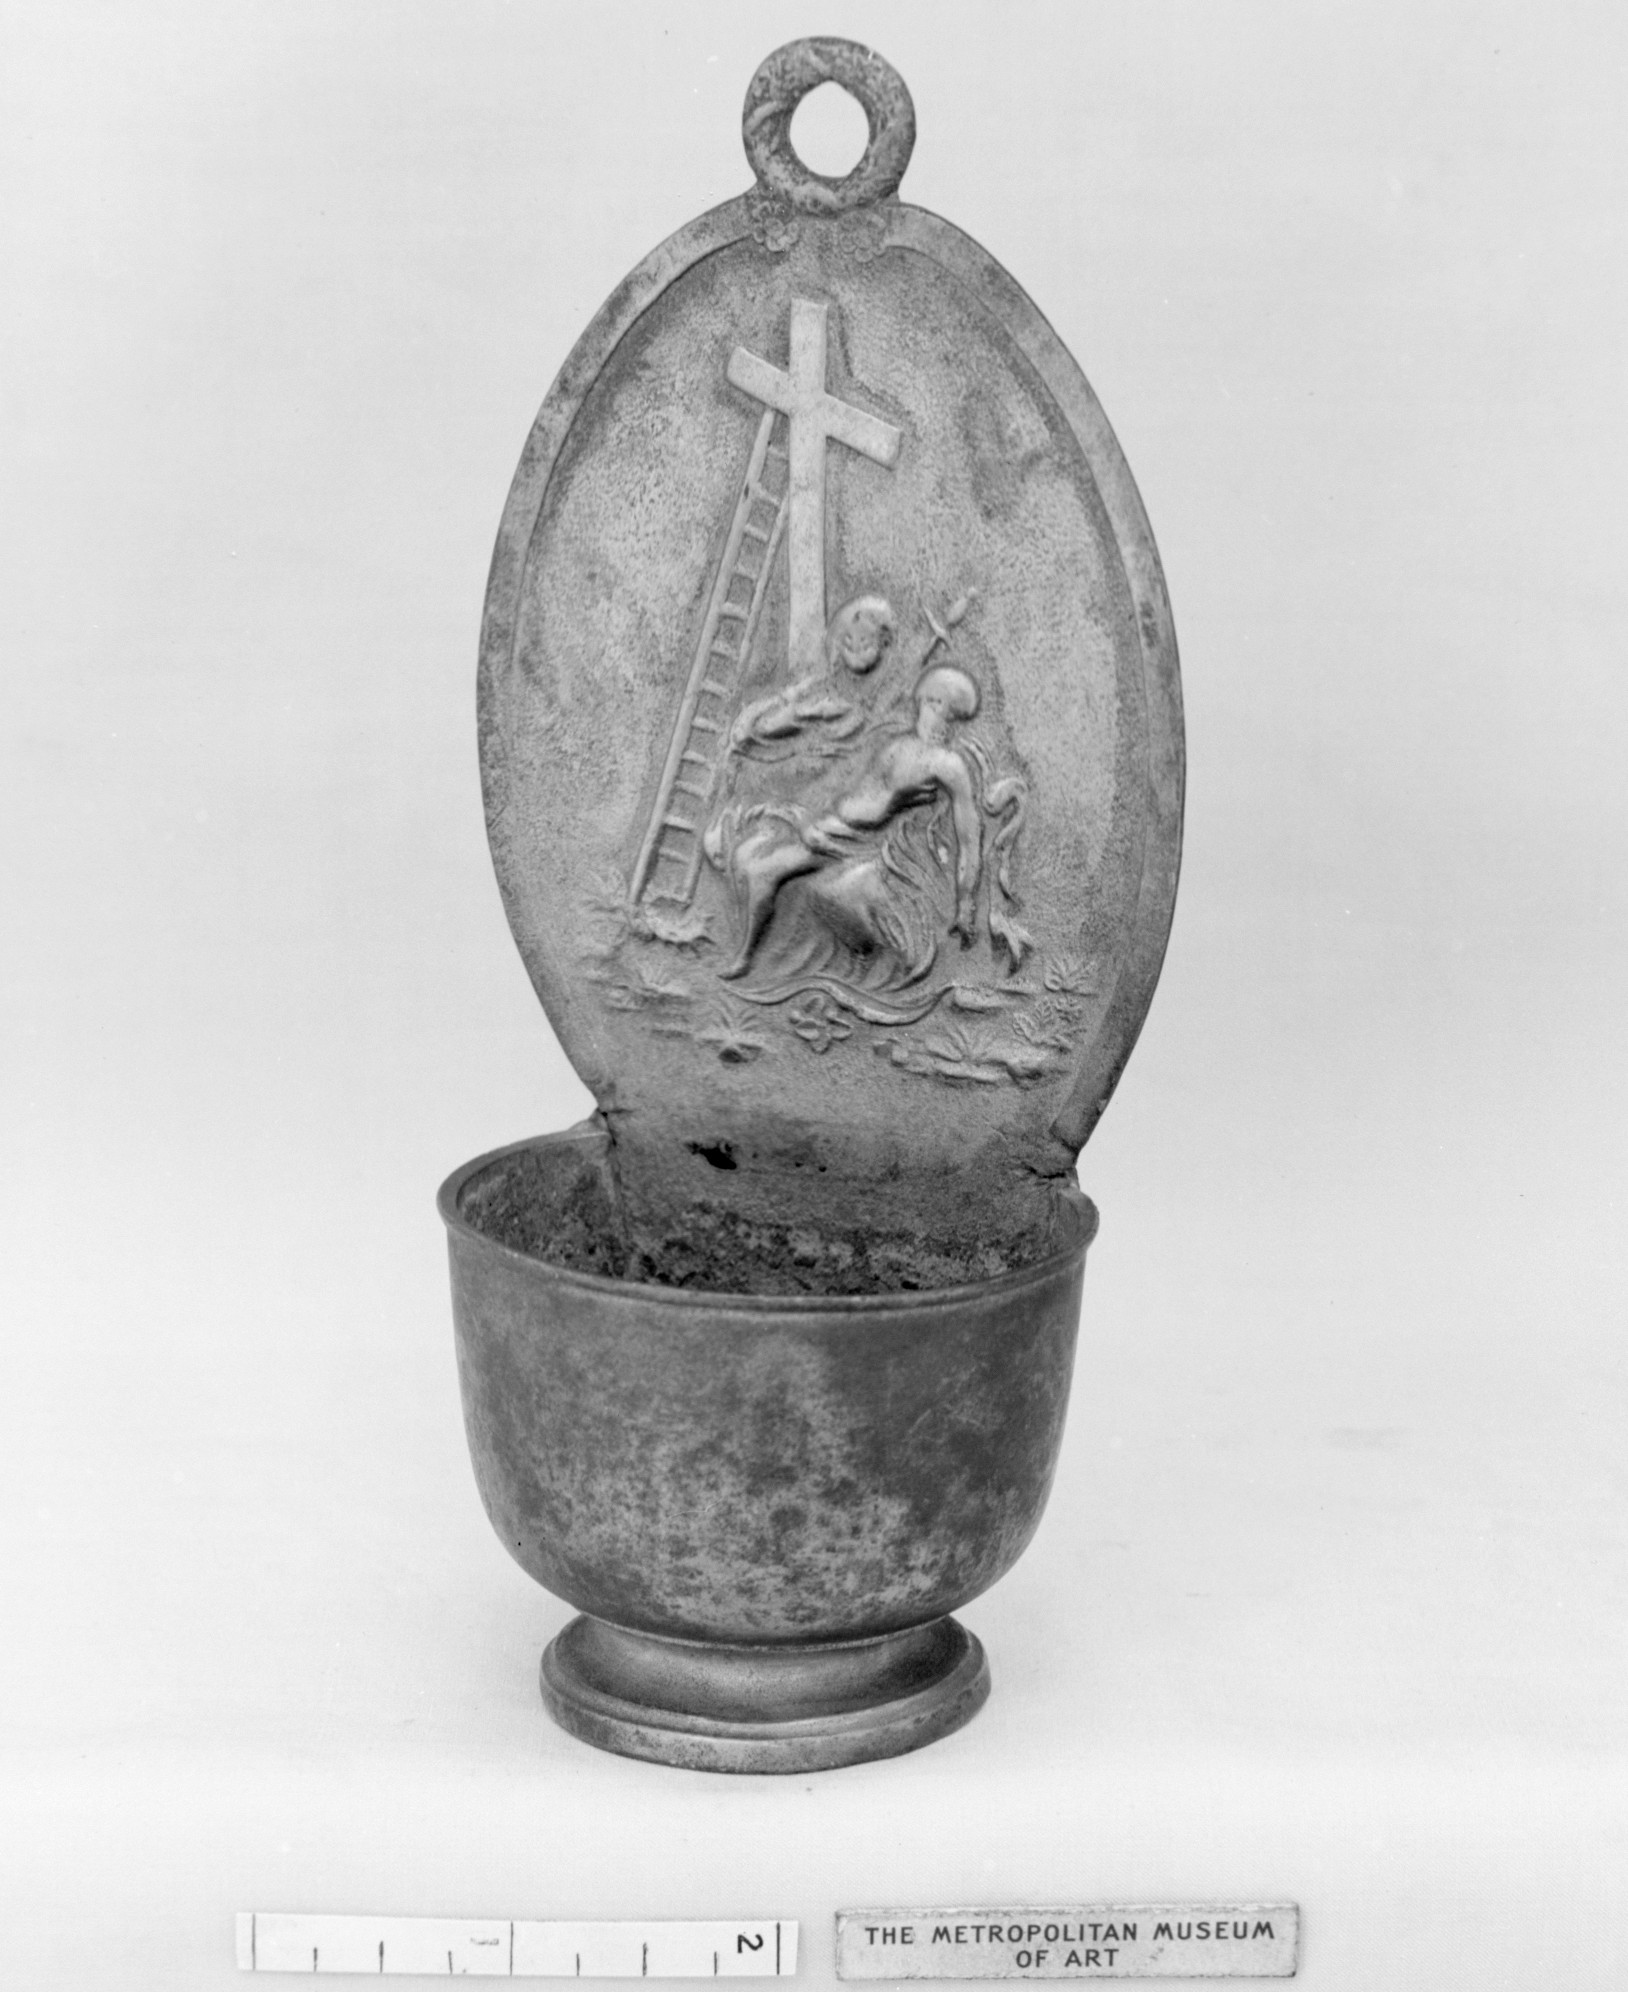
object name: bénitier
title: Small or hanging bénitier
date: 1601-1700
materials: pewter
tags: cross,lamentation